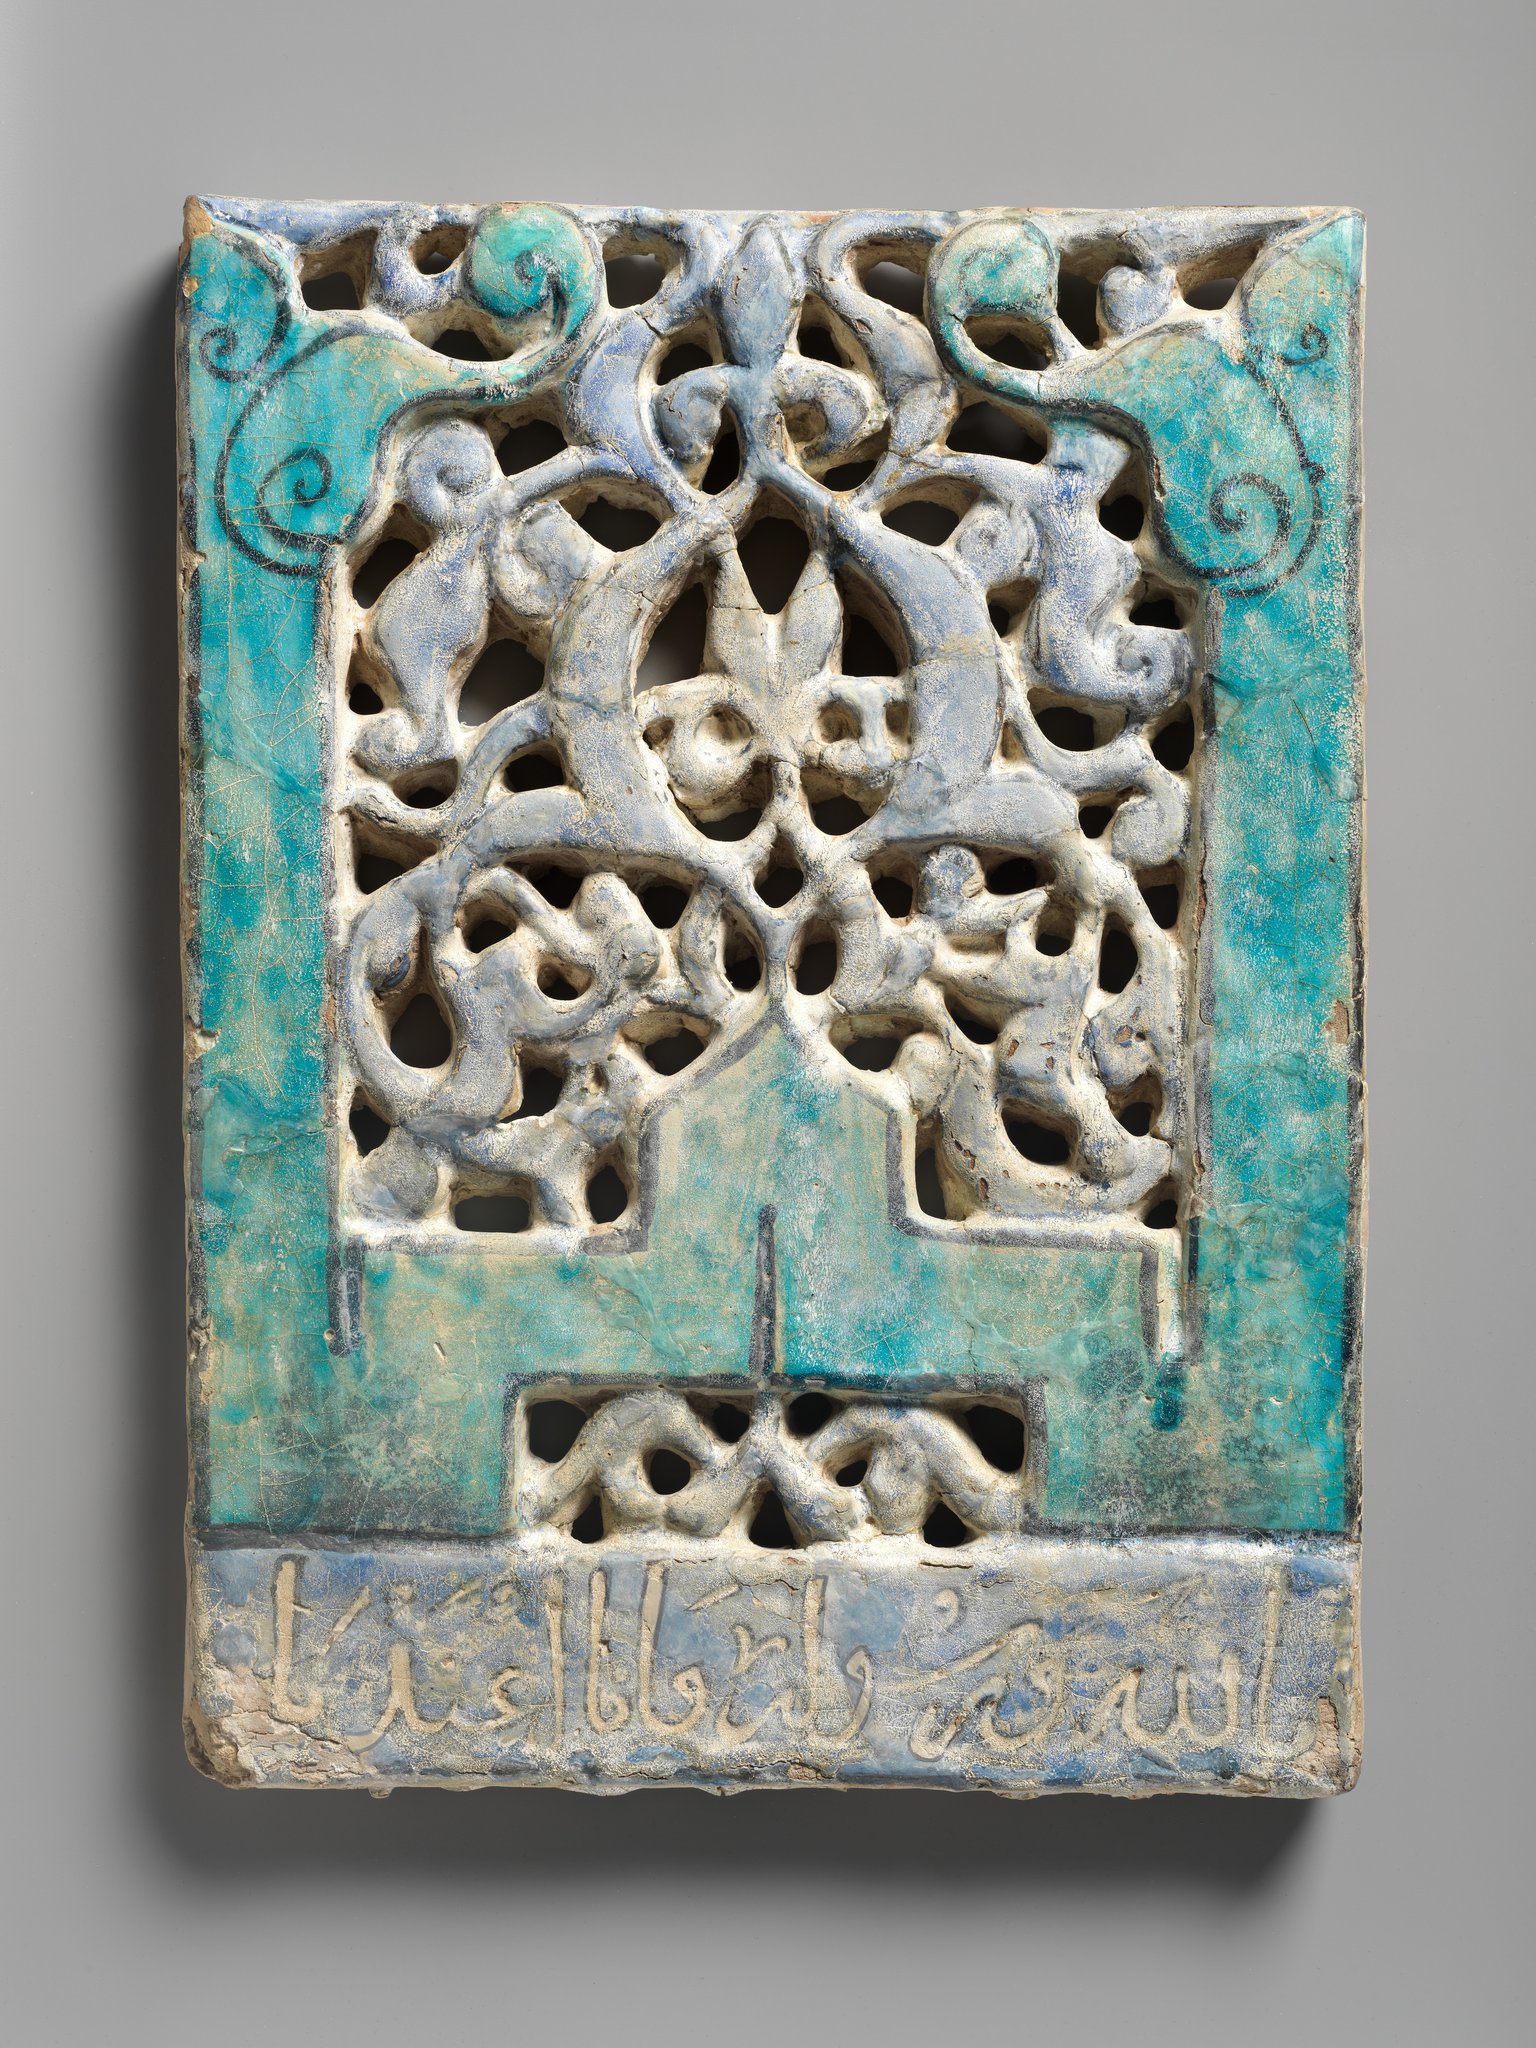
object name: screen fragment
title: Pierced Screen with Letters against a Vegetal Pattern (and Additional Fragments of a Screen)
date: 1101-1200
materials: stonepaste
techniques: glazing, painting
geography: iran